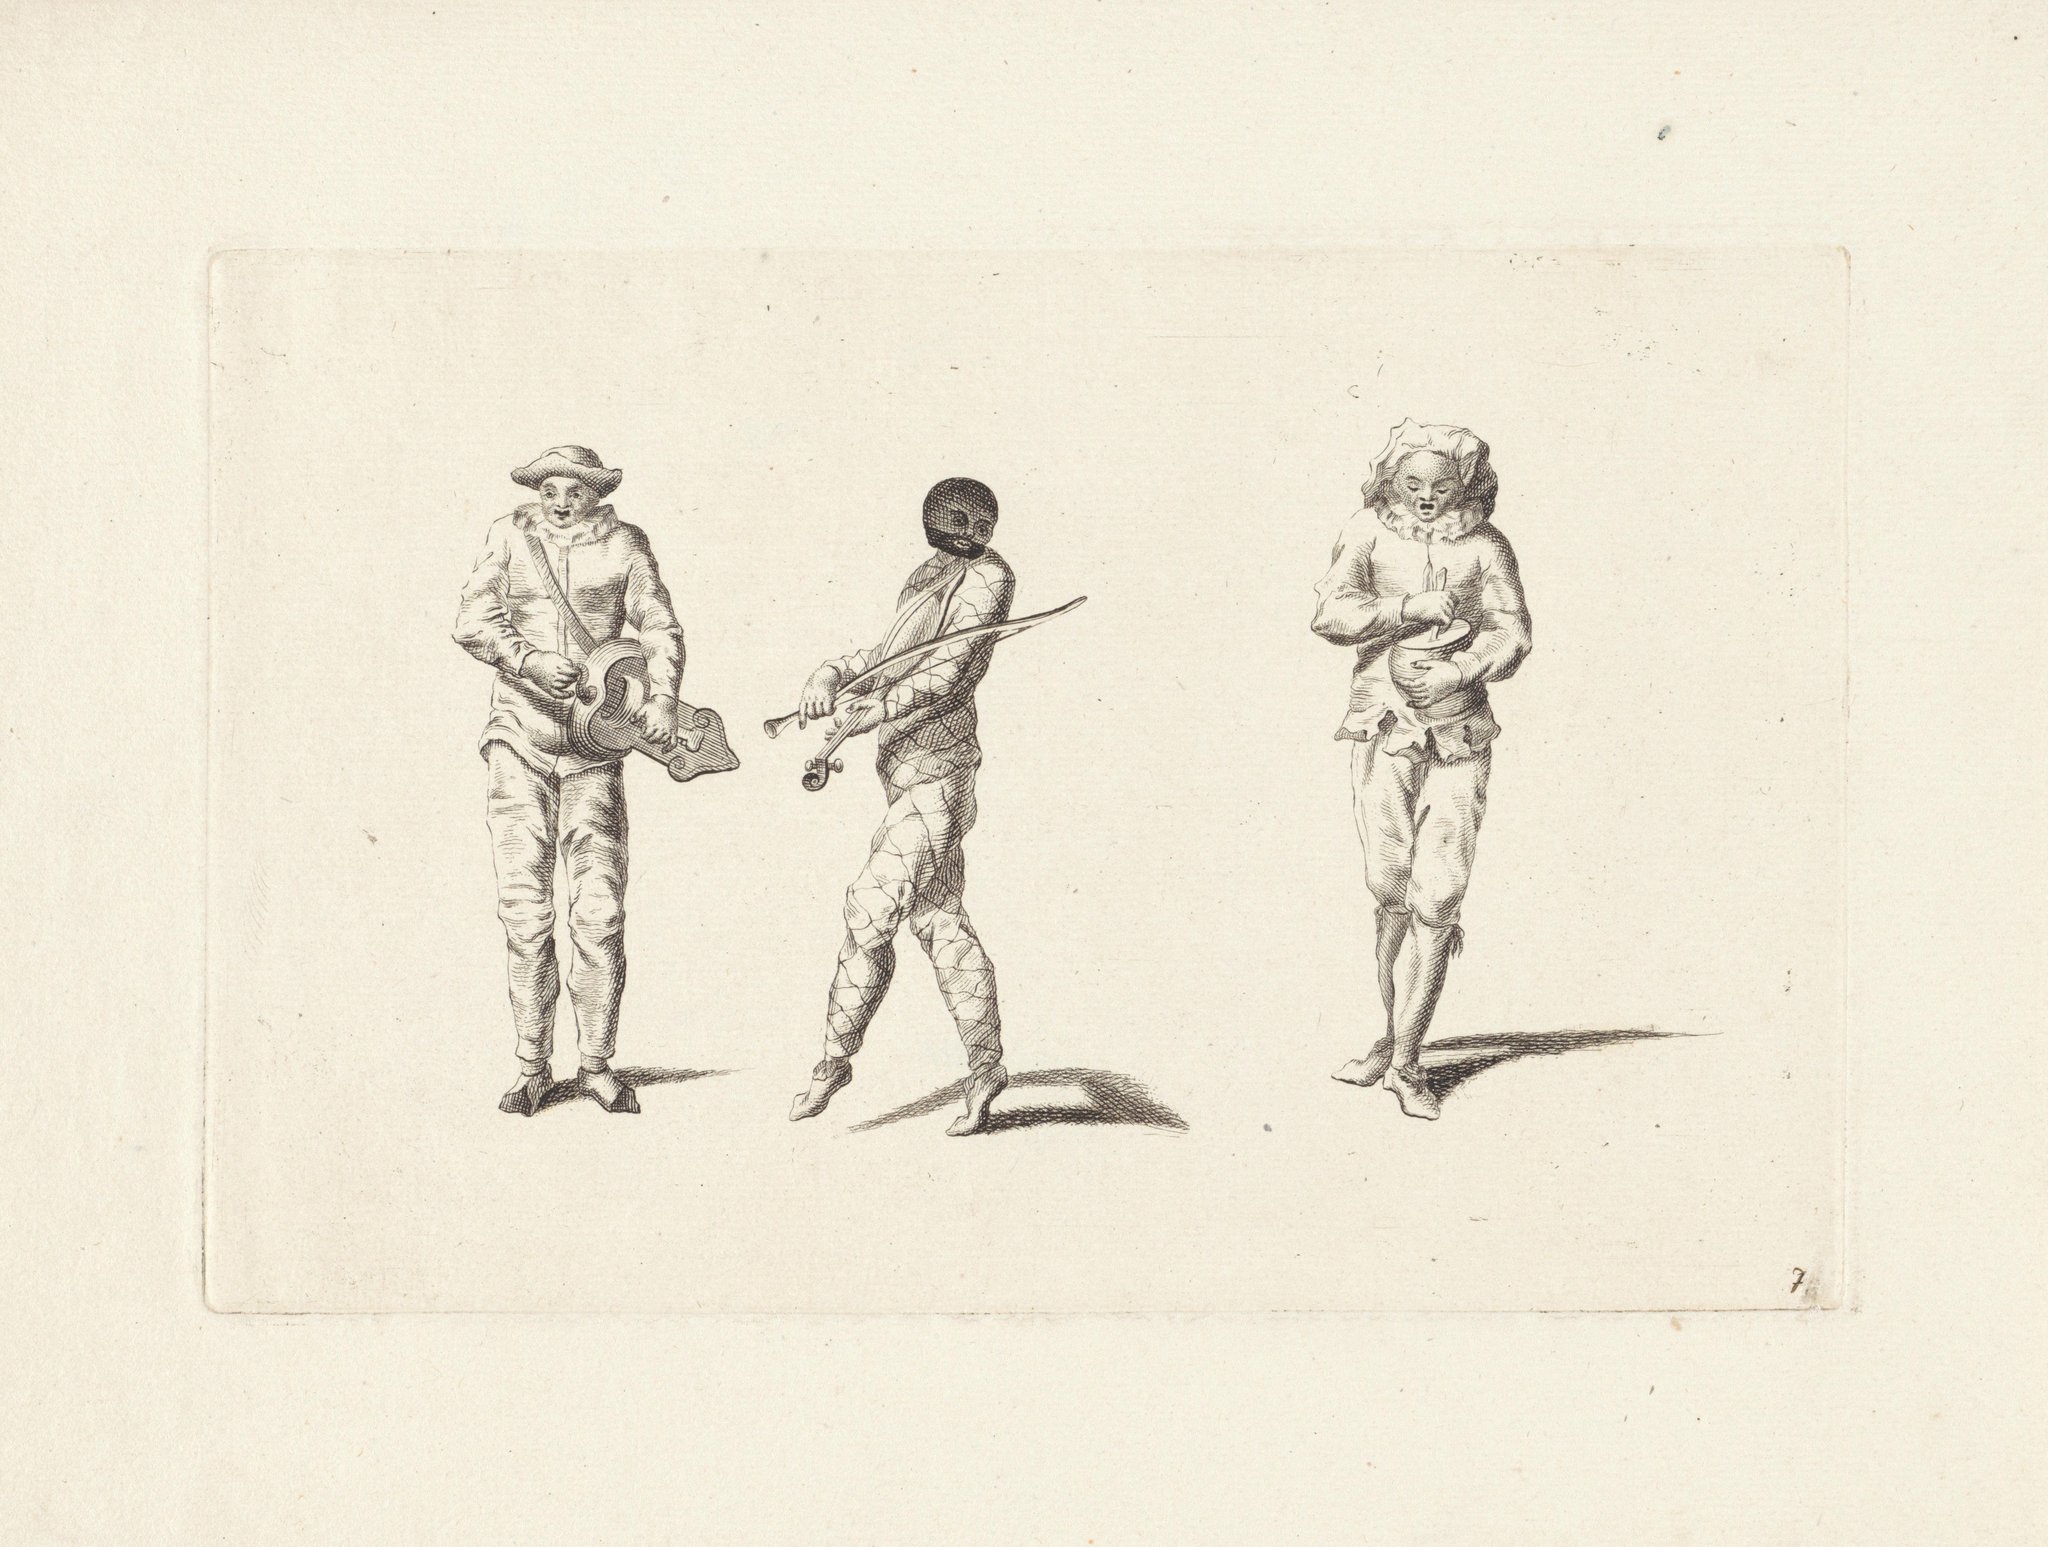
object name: print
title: Koorddansers en acrobaten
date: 1728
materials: paper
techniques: engraving, etching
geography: amsterdam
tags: hurdy-gurdy, violin, fiddle, improvised musical instruments: rumbling pot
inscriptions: collector's mark: Lugt 2228